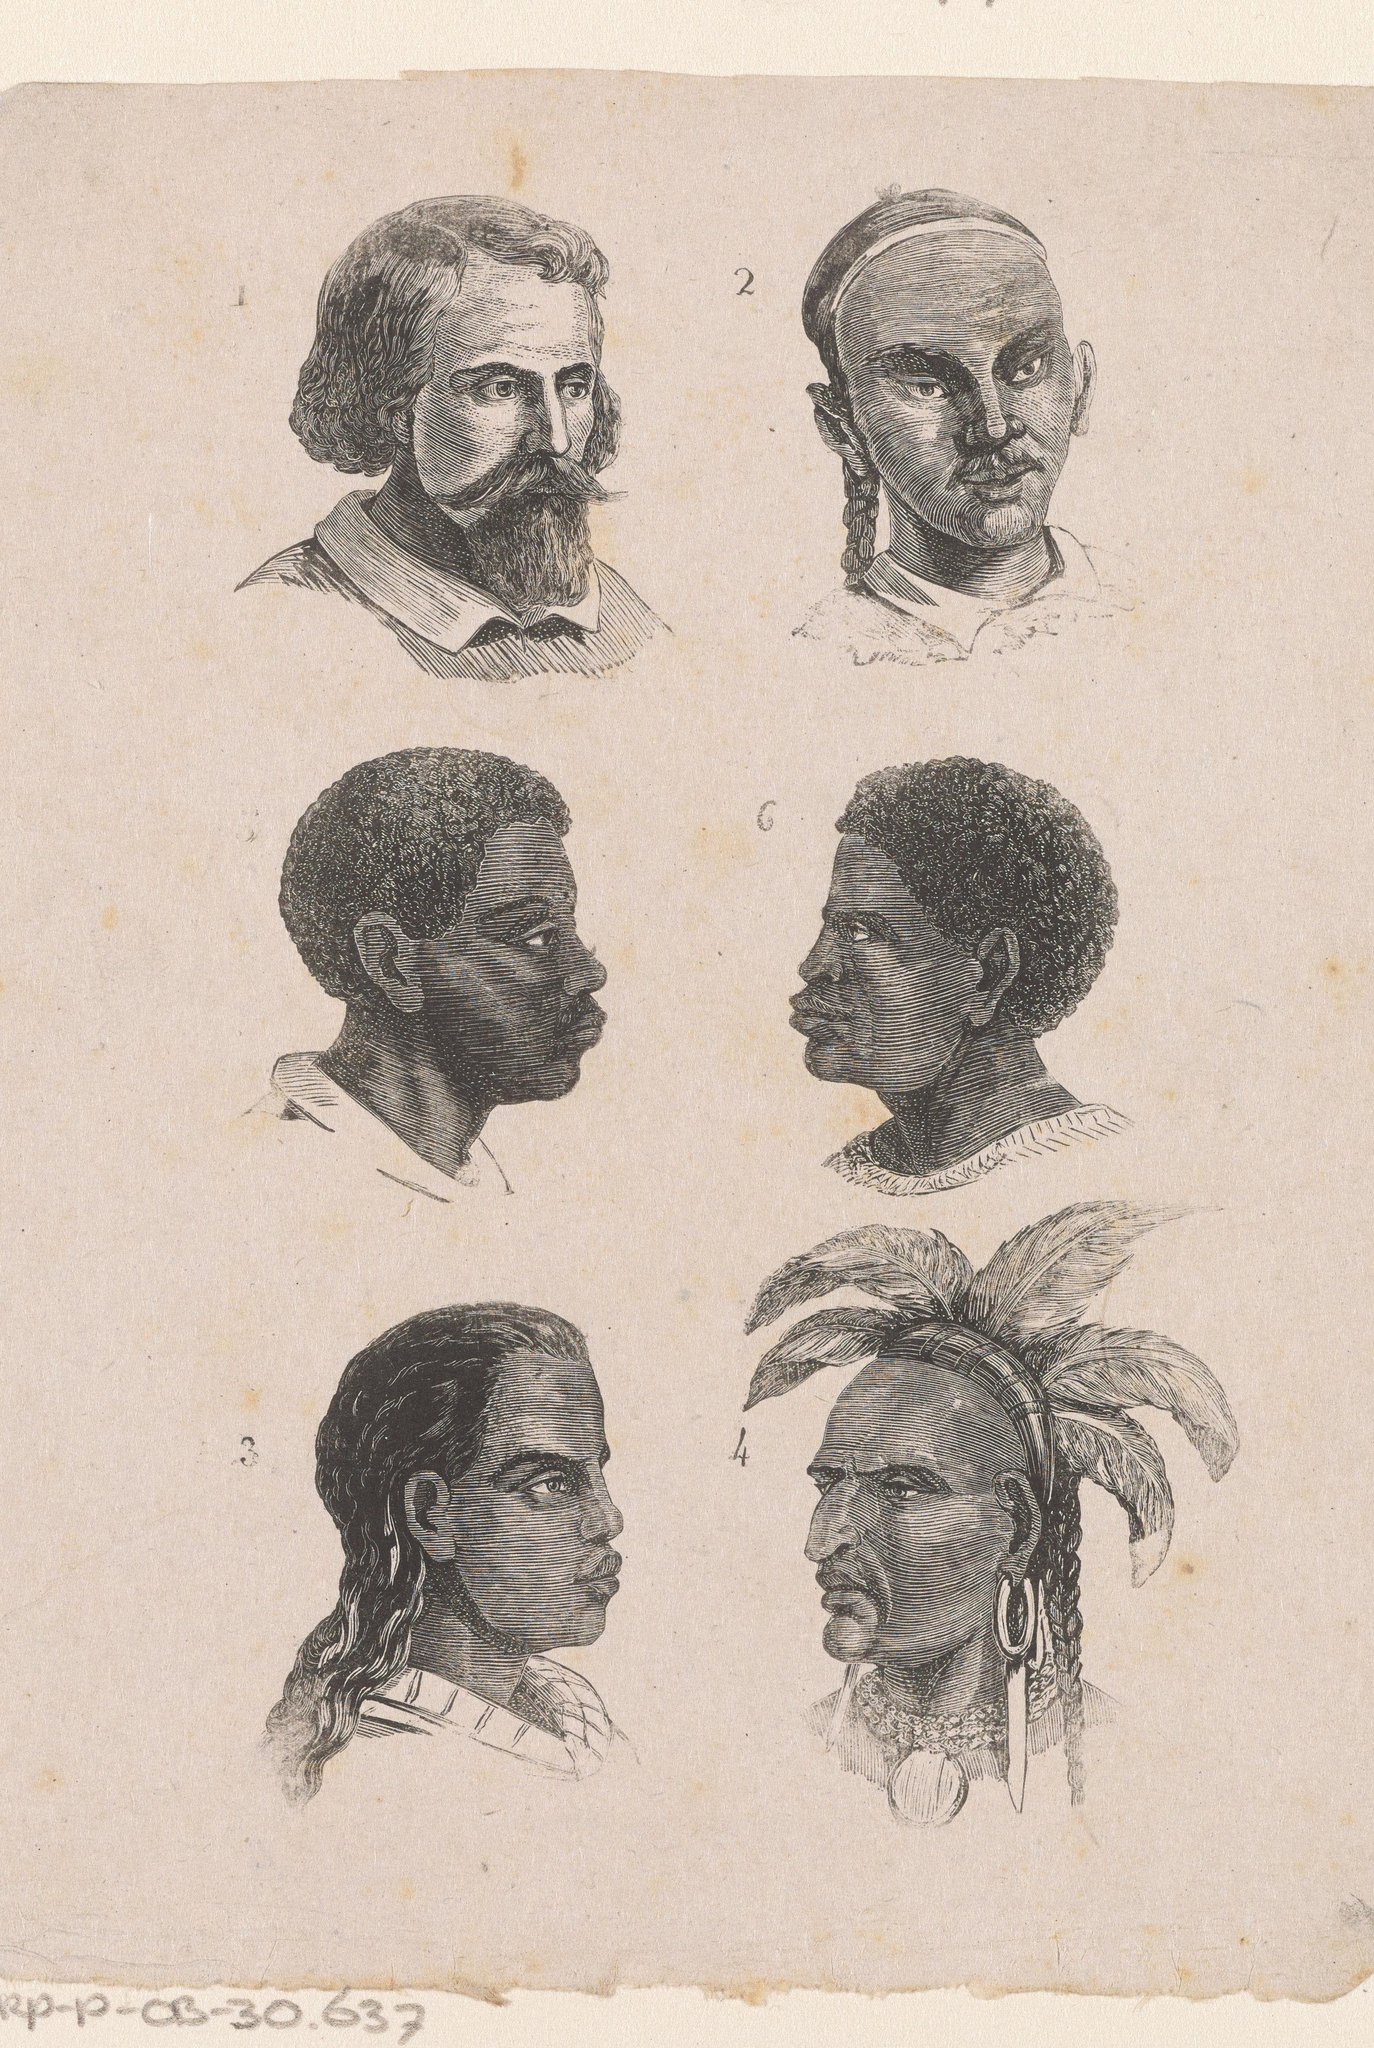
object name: print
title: Zes mannenhoofden van verschillende menselijke rassen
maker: isaac weissenbruch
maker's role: print maker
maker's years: 1826-1912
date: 1836-1912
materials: paper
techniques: engraving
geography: netherlands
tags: head (human), human races, peoples and nationalities (other than prehistoric or extinct)